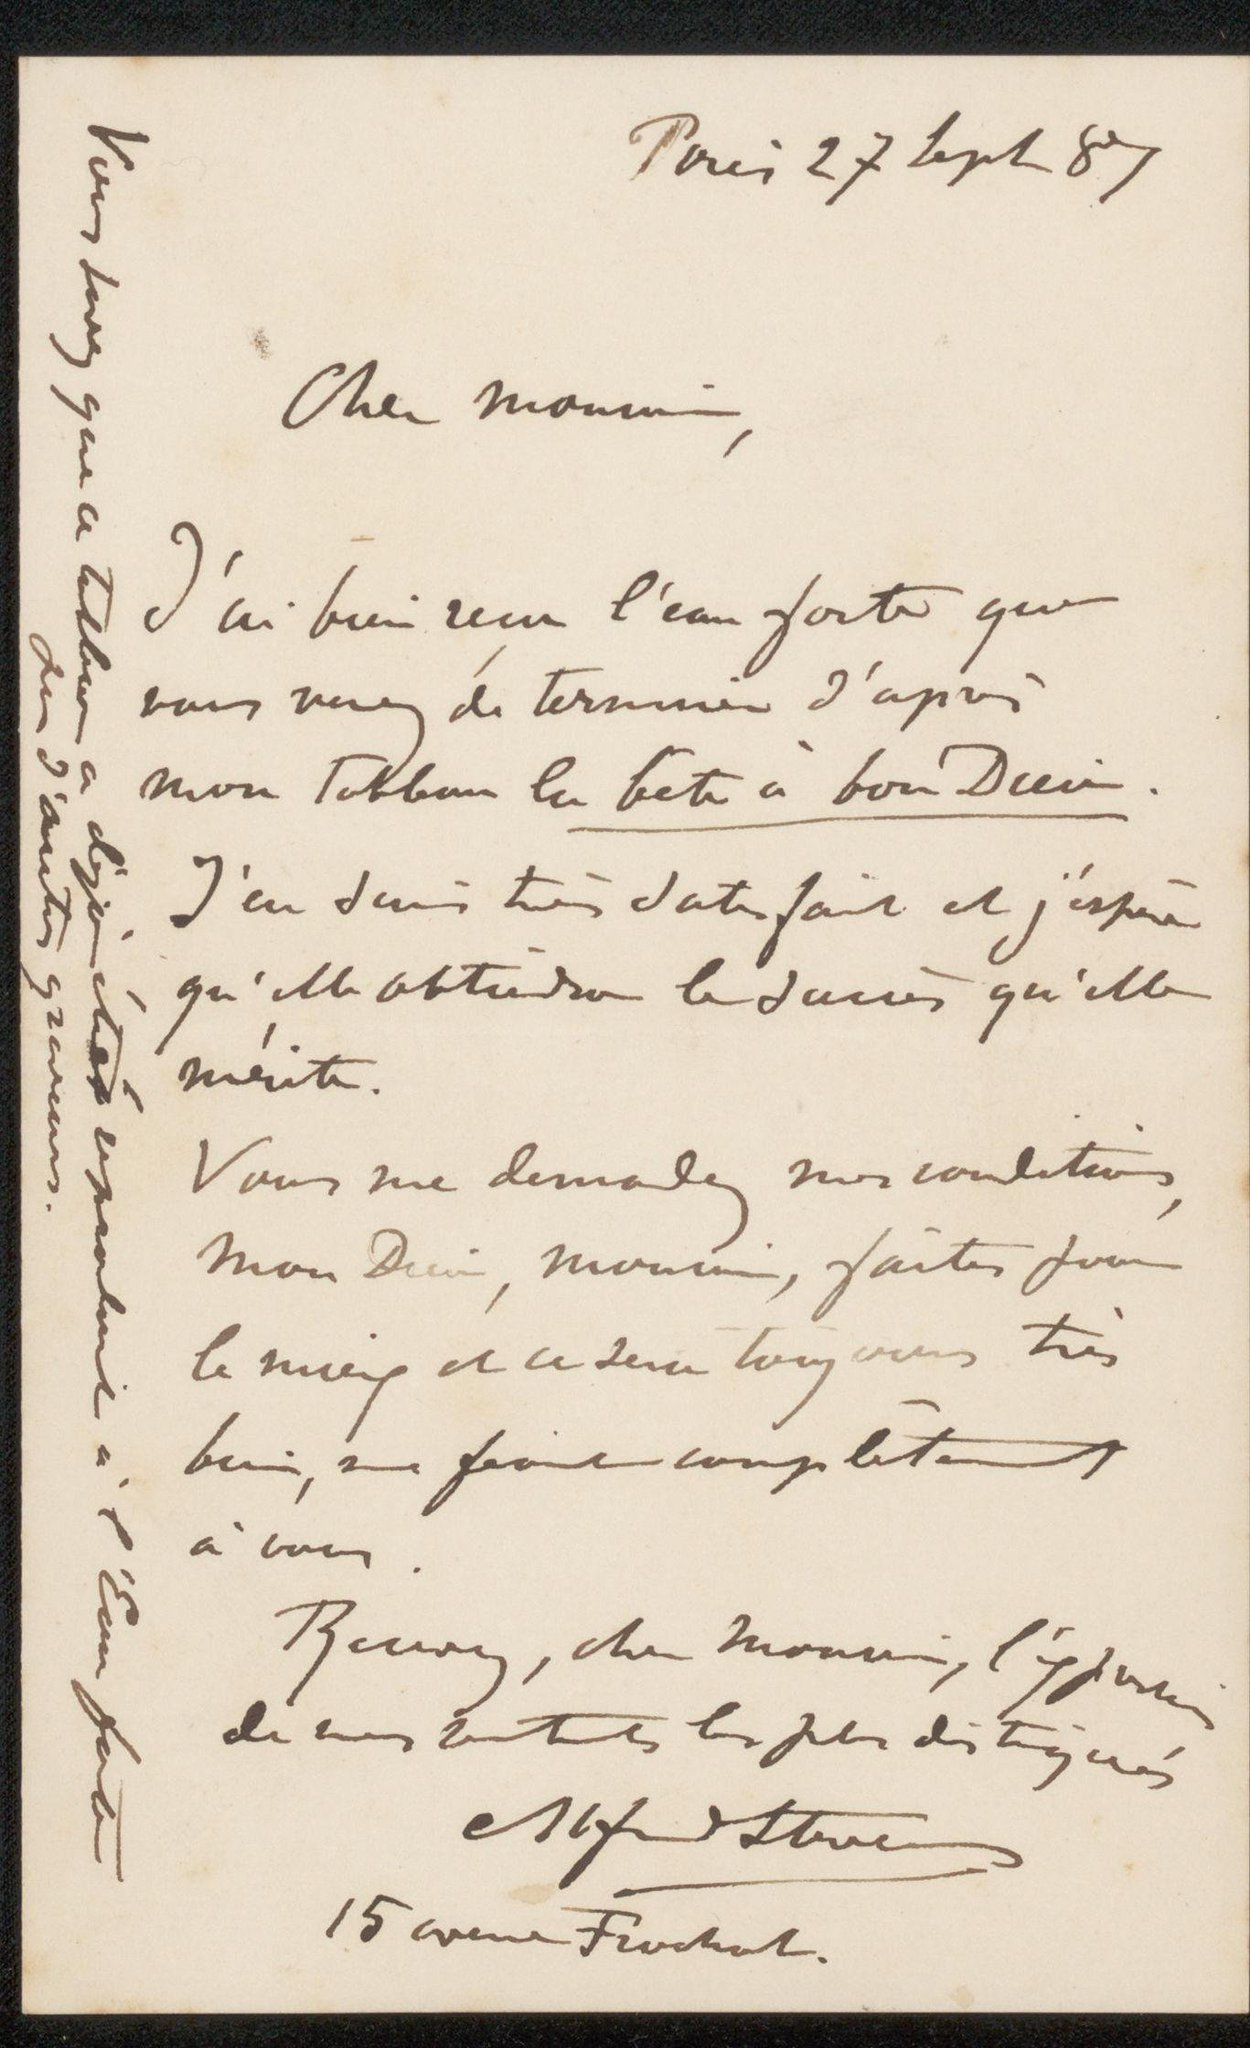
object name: letter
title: Brief aan Philip Zilcken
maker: alfred stevens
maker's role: painter, print maker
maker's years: 1823-1906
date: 1887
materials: ink, paper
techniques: pen, writing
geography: paris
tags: draughtsman, philip zilcken, the graphic arts, painting (including book-illumination, miniature-painting)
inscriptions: watermark, collector's mark: ‘RPK’